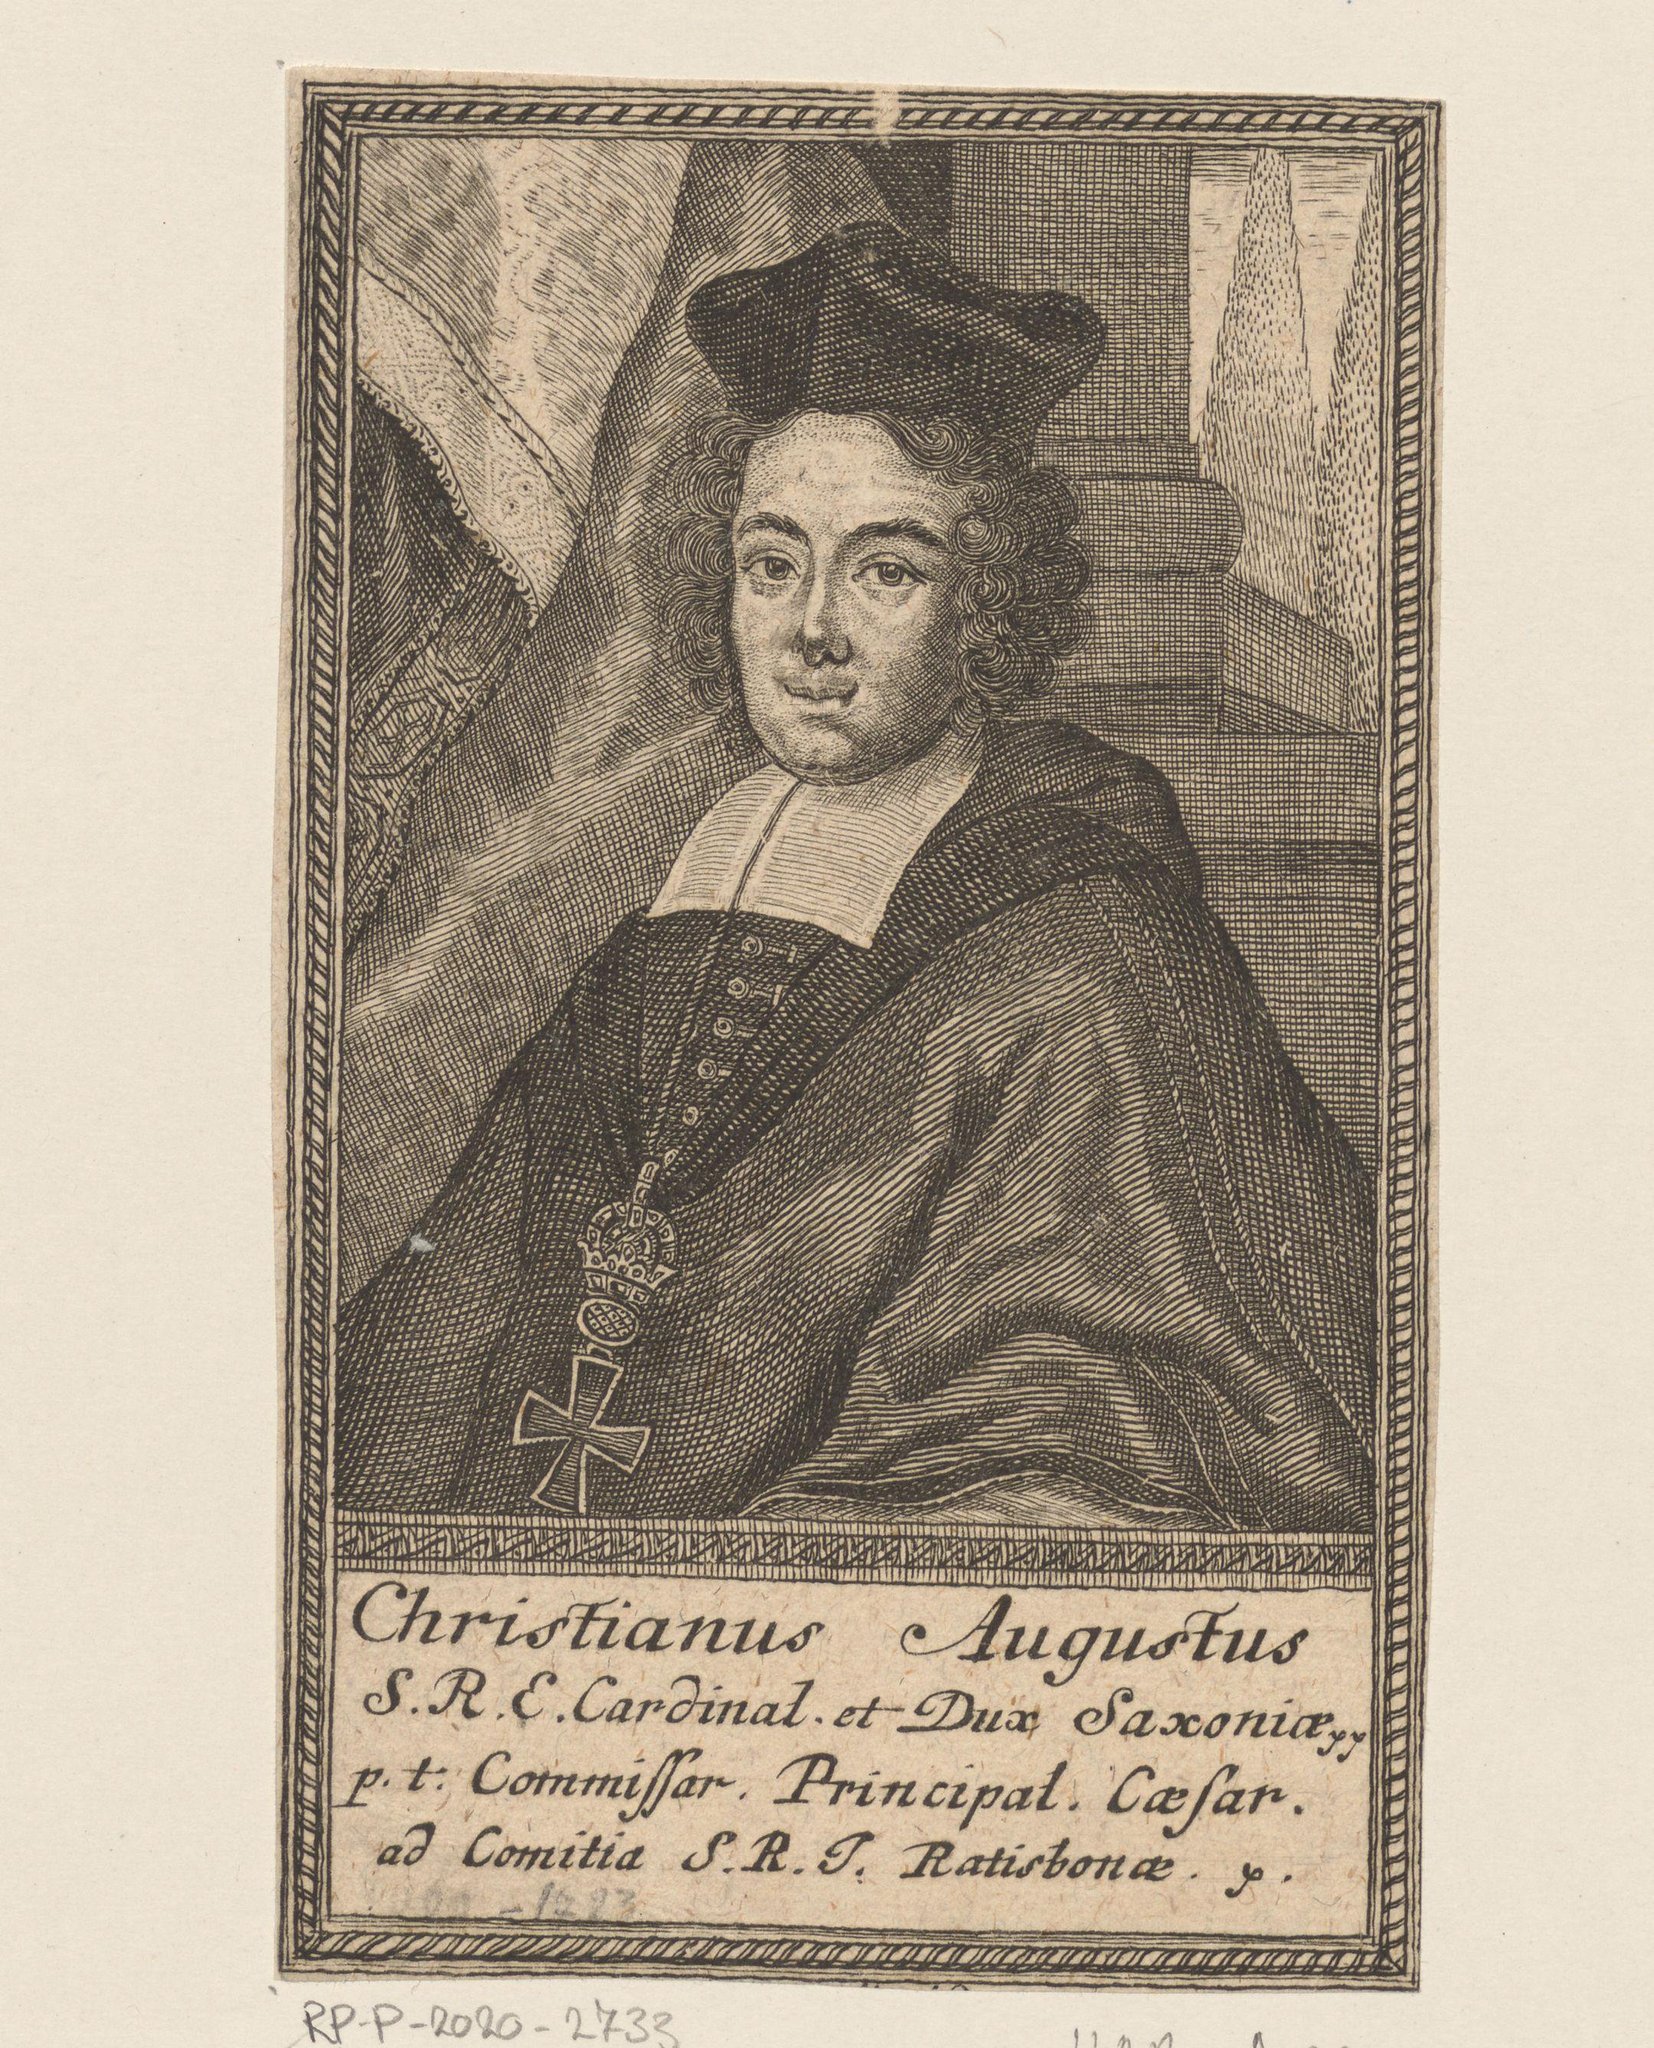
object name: print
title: Portret van Christian August, hertog van Saksen-Zeitz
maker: Anonymous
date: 1723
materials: paper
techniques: engraving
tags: historical persons, ruler, sovereign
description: Prent mogelijk uit: Faber, Anton. Europäische Staats-Cantzley. Ulm, Frankfurt & Leipzig: s.n., 1723, dl. 41.